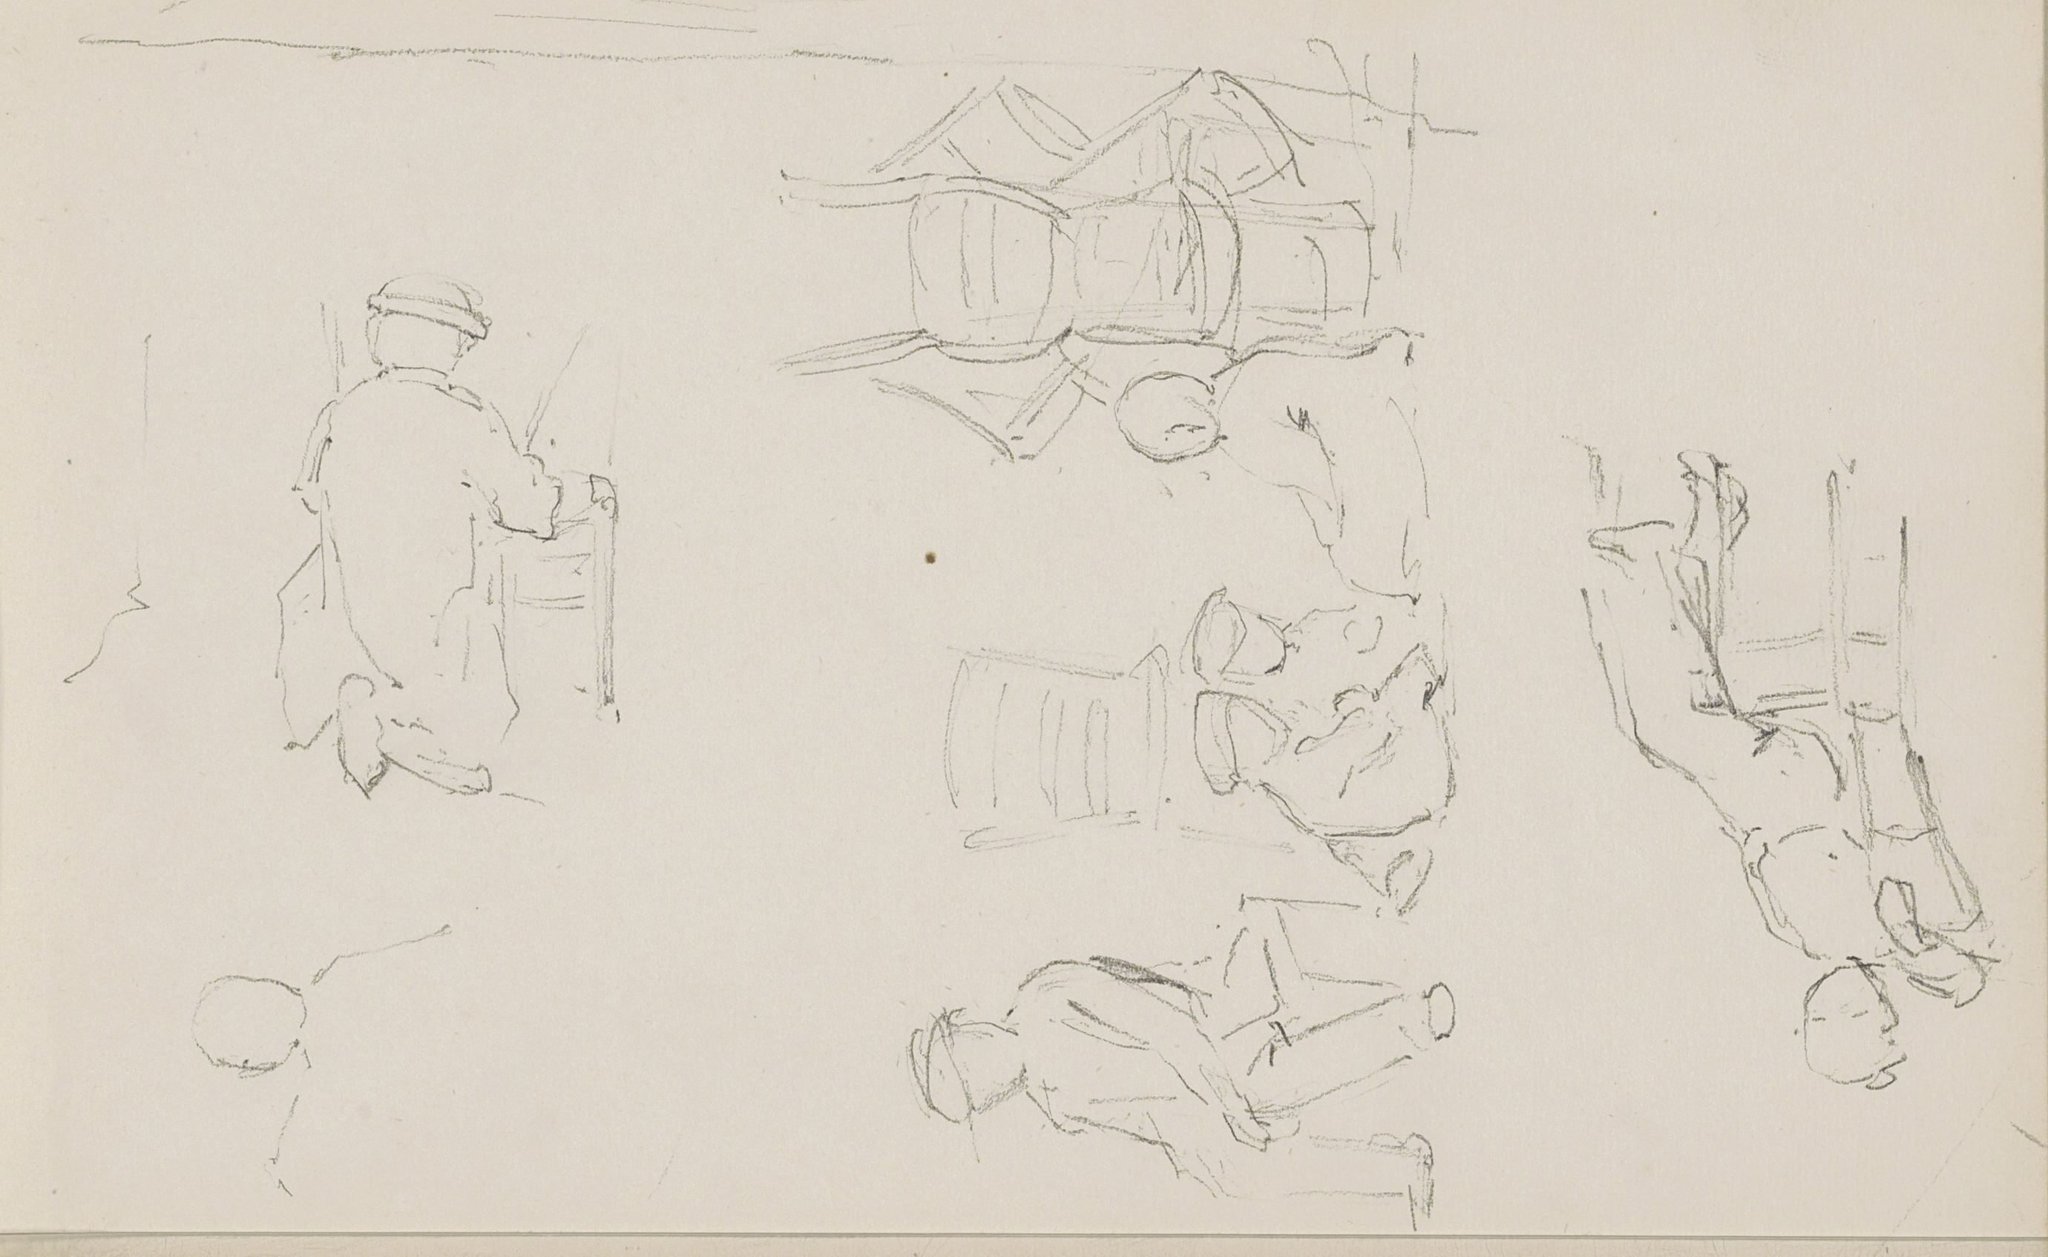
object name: sketchbook leaf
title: Studieblad, onder andere met kinderen spelend op de vloer en opgestapelde stoelen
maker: a.a.l. de grammont-hubrecht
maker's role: draughtsman, painter, print maker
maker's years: 1855-1913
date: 1865-1913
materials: chalk, paper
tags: sitting figure, children's games and plays, boy (child between toddler and youth), girl (child between toddler and youth), chair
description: Tevens studies van een meisje zittend op een stoel en een jongen spelend bij een stoel. Blad 12 recto uit een schetsboek met 28 bladen.